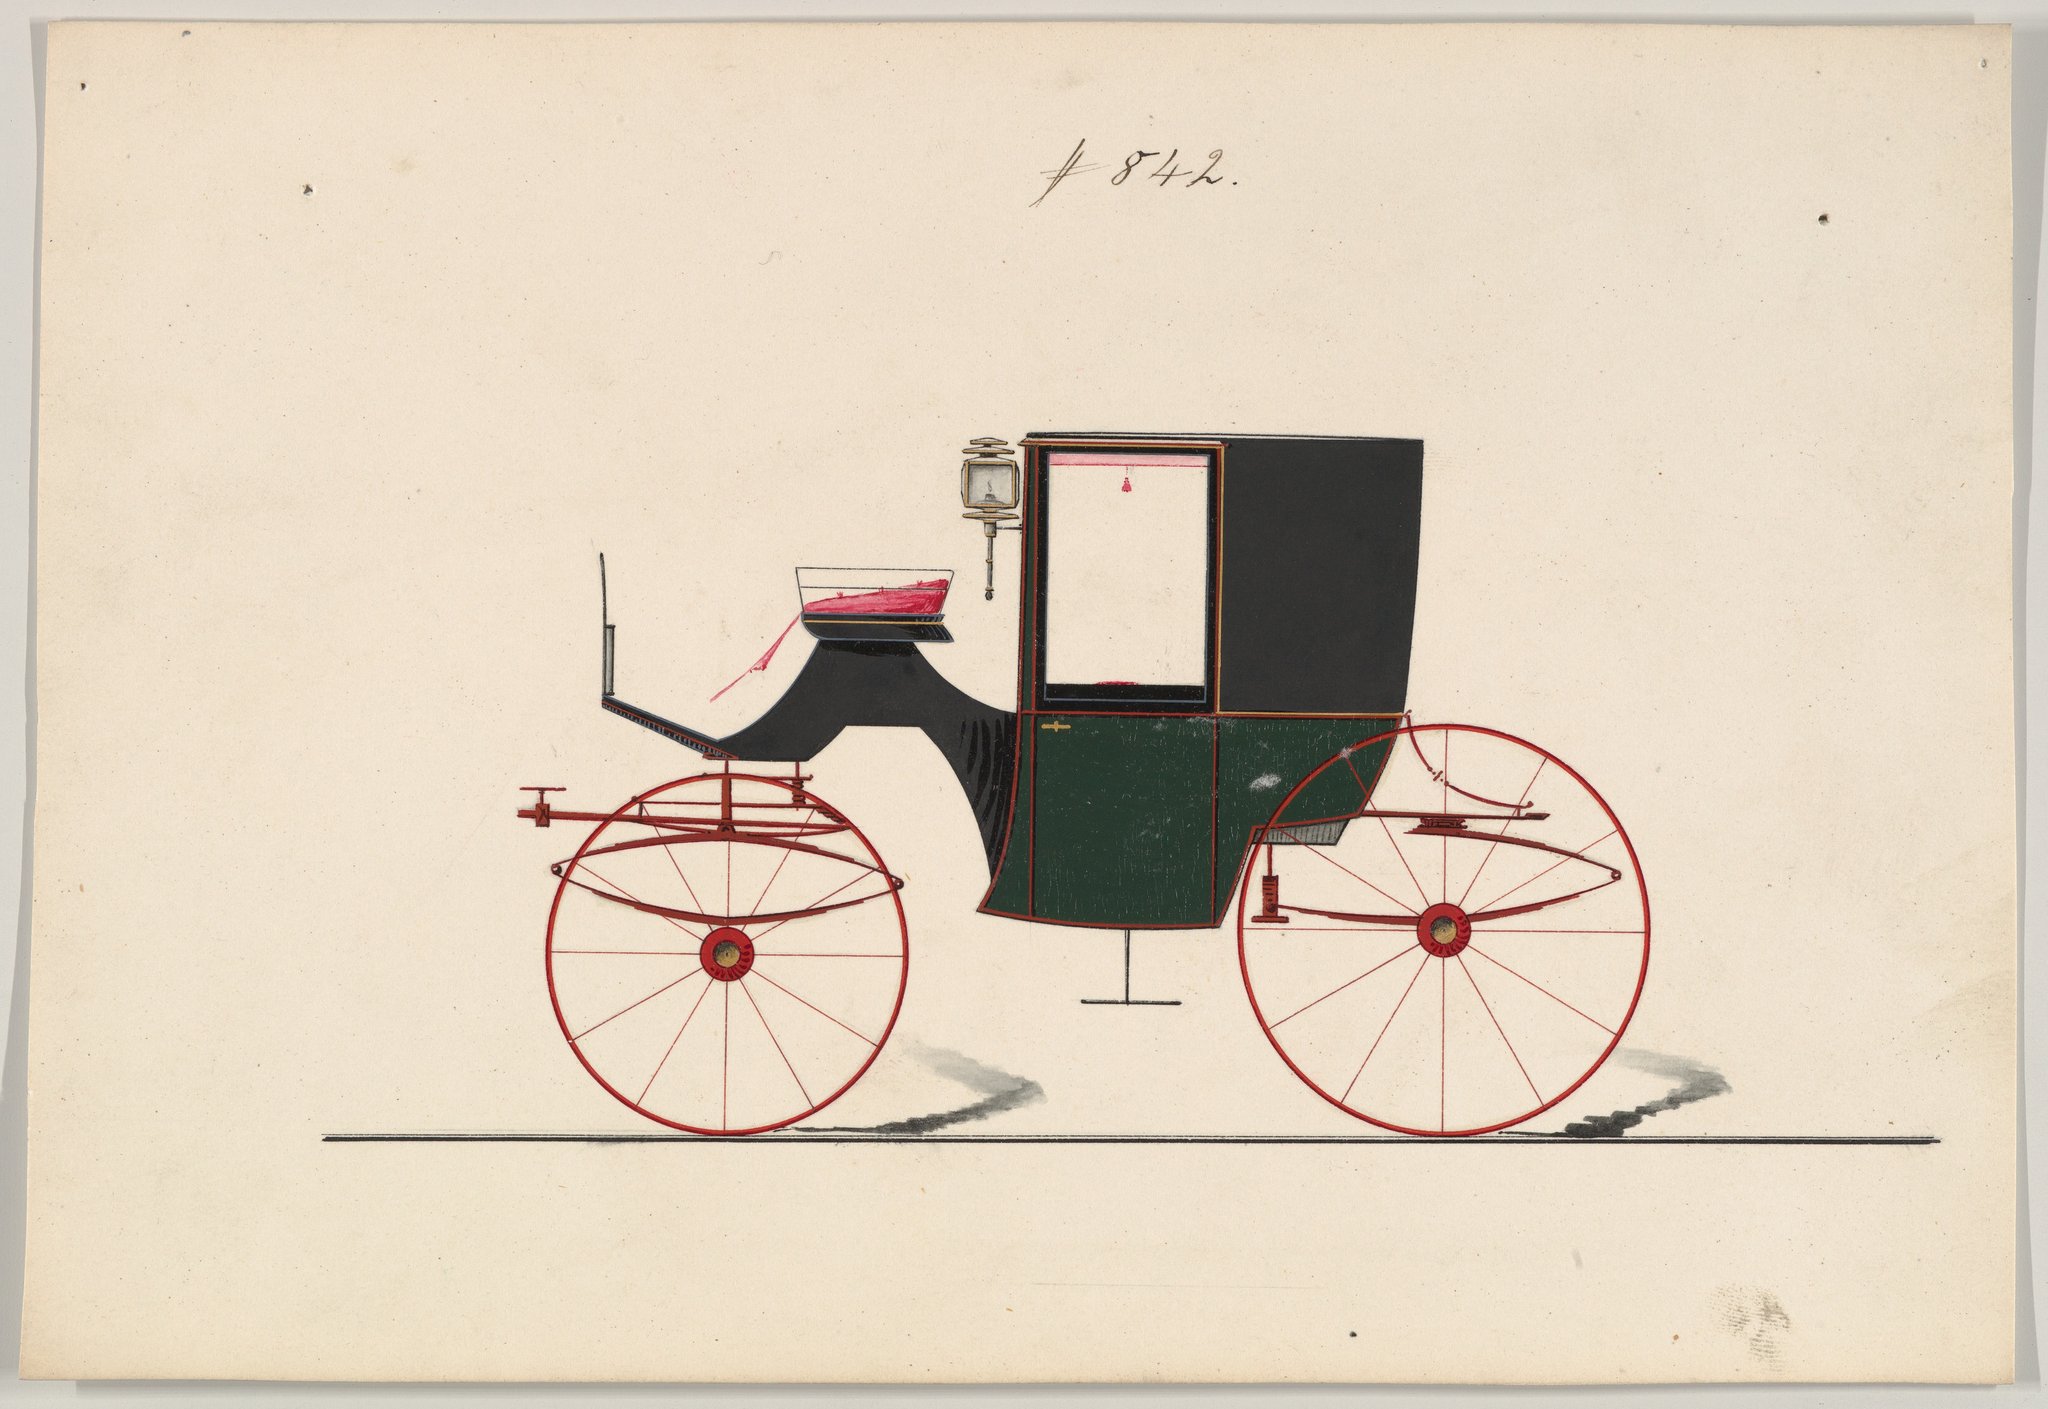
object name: drawing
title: Coupe # 842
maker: brewster & co.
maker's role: manufacturer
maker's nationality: american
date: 1865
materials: gouache, gum arabic, ink, watercolor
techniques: pen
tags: carriages